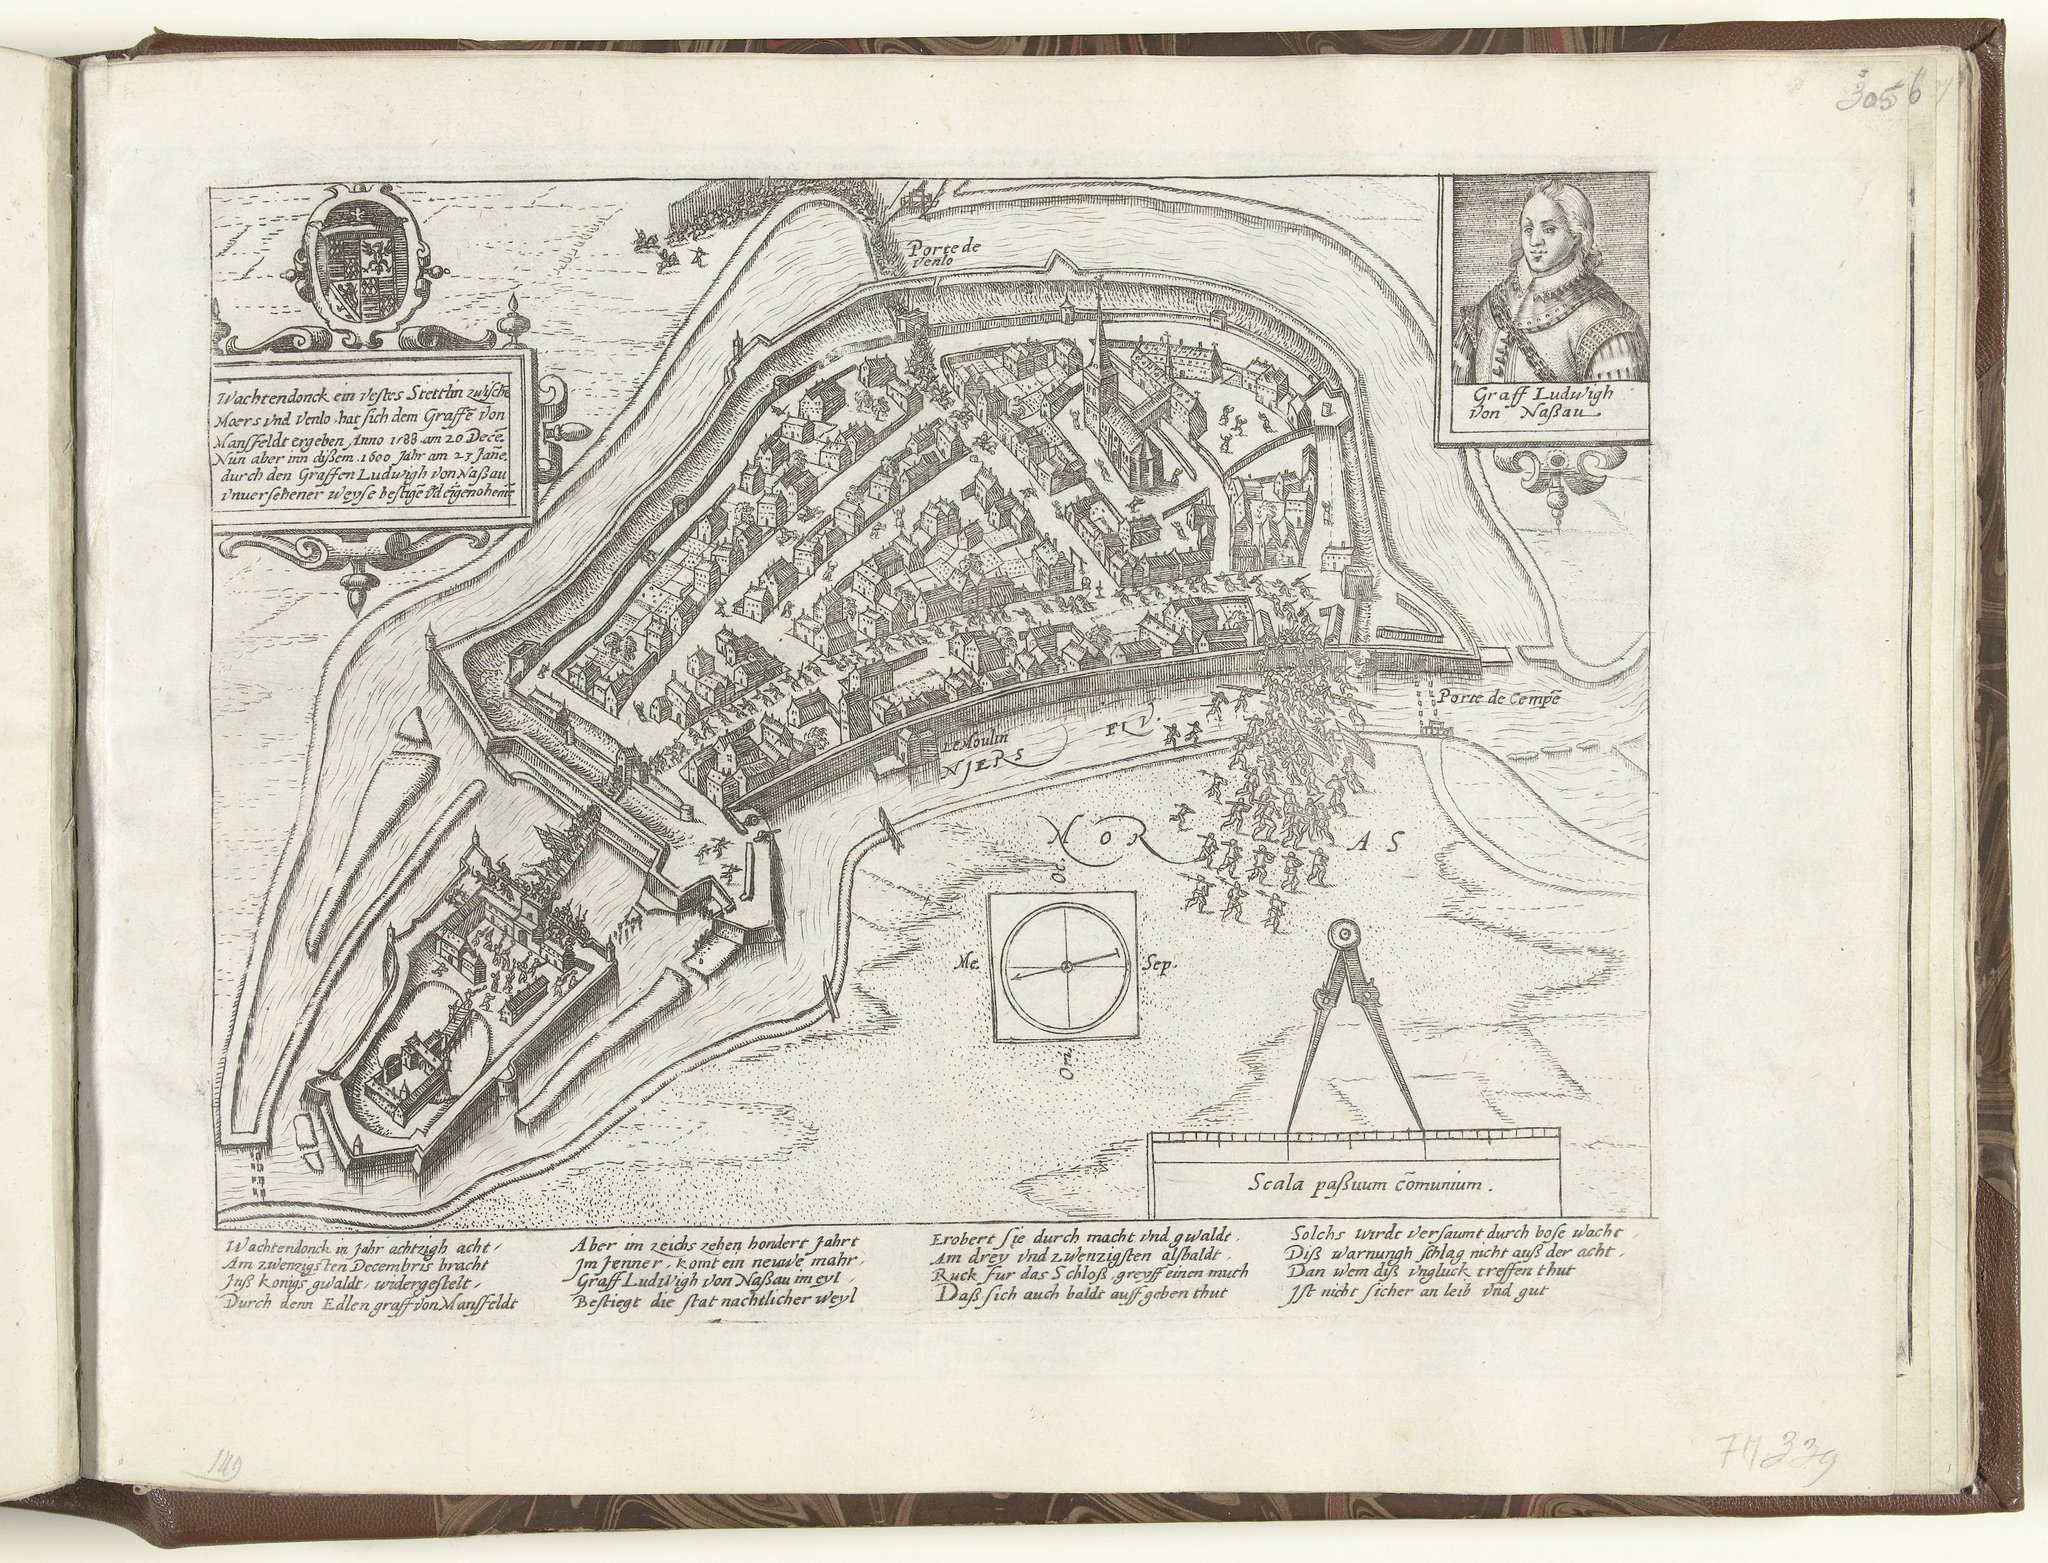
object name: print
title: Lodewijk van Nassau verovert Wachtendonk, 1600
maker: frans hogenberg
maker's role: print maker, publisher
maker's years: 1538-1590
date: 1600-1602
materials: paper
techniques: engraving, etching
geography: cologne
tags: capture of city (after the siege)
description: Verovering van Wachtendonk door het Staatse leger onder Lodewijk Gunther, graaf van Nassau, 23 januari 1600. Gezicht op de ommuurde stad, rechtsboven inzet met portret van Lodewijk van Nassau, linksboven een cartouche met tekst. Rechtsonder een passer met schaal. Met onderschrift van 16 regels in het Duits. Ongenummerd.